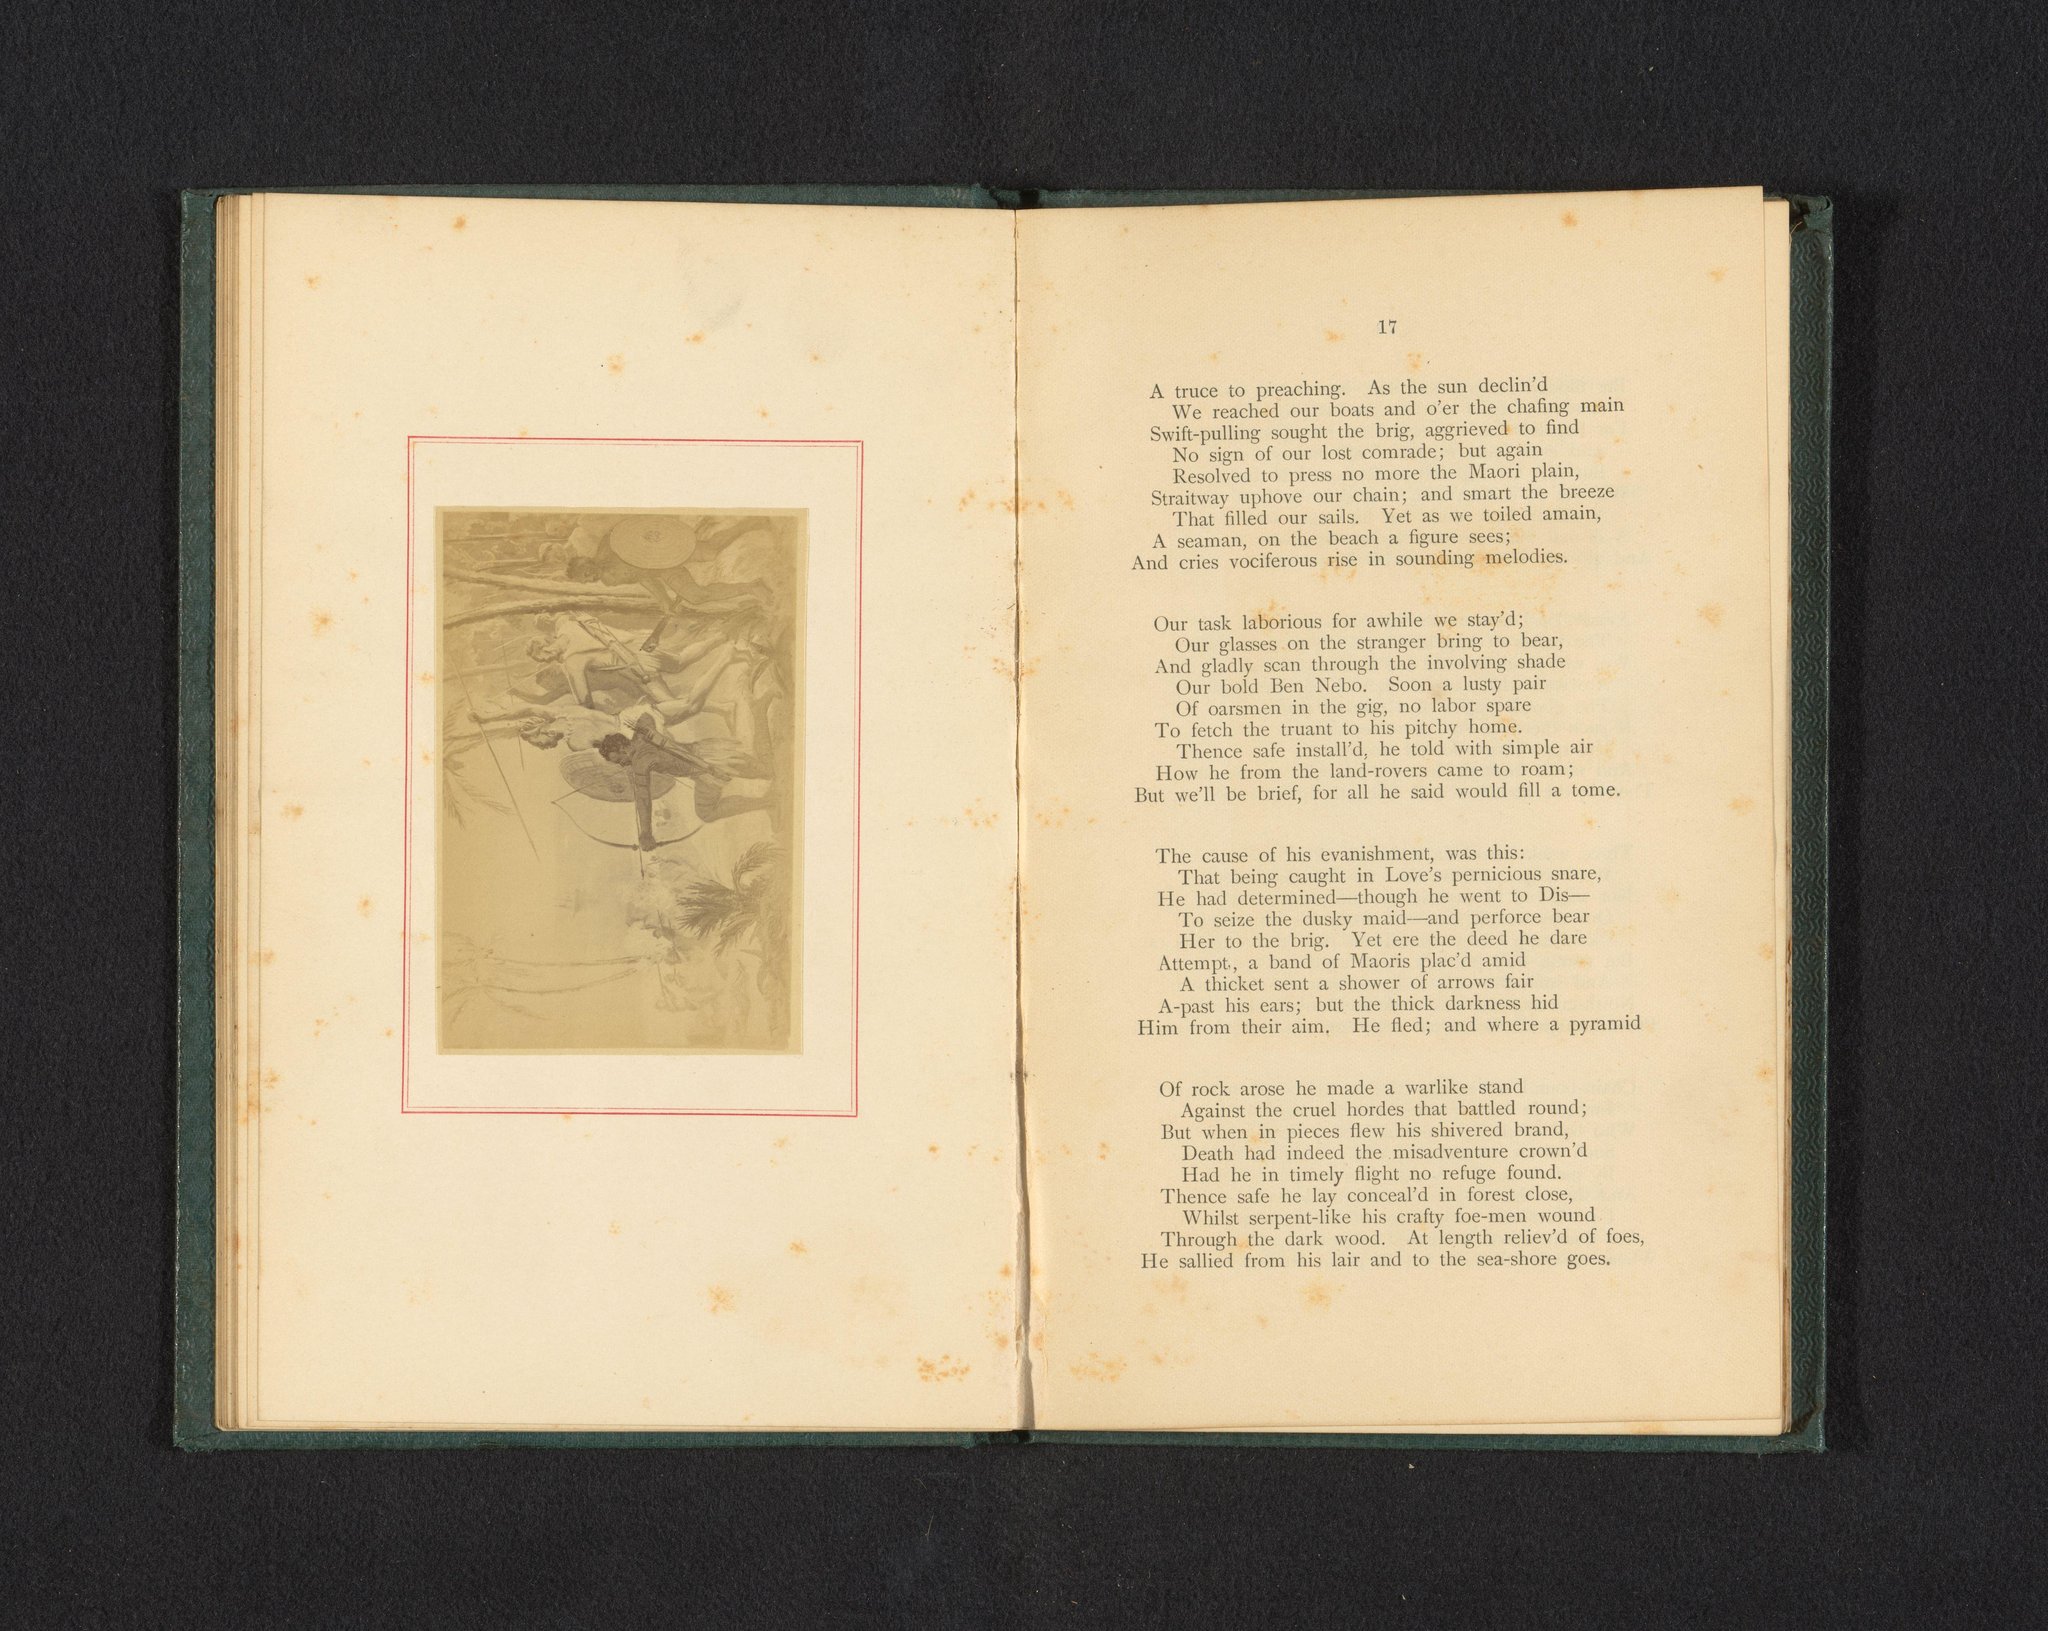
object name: photograph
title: Fotoreproductie van een schilderij, voorstellende krijgers met speren en pijl en boog vallen mannen met geweren aan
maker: flaglor and perkins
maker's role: fotograaf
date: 1866-1871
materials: photographic support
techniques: albumen print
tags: battle, firearms: rifle, casting weapons